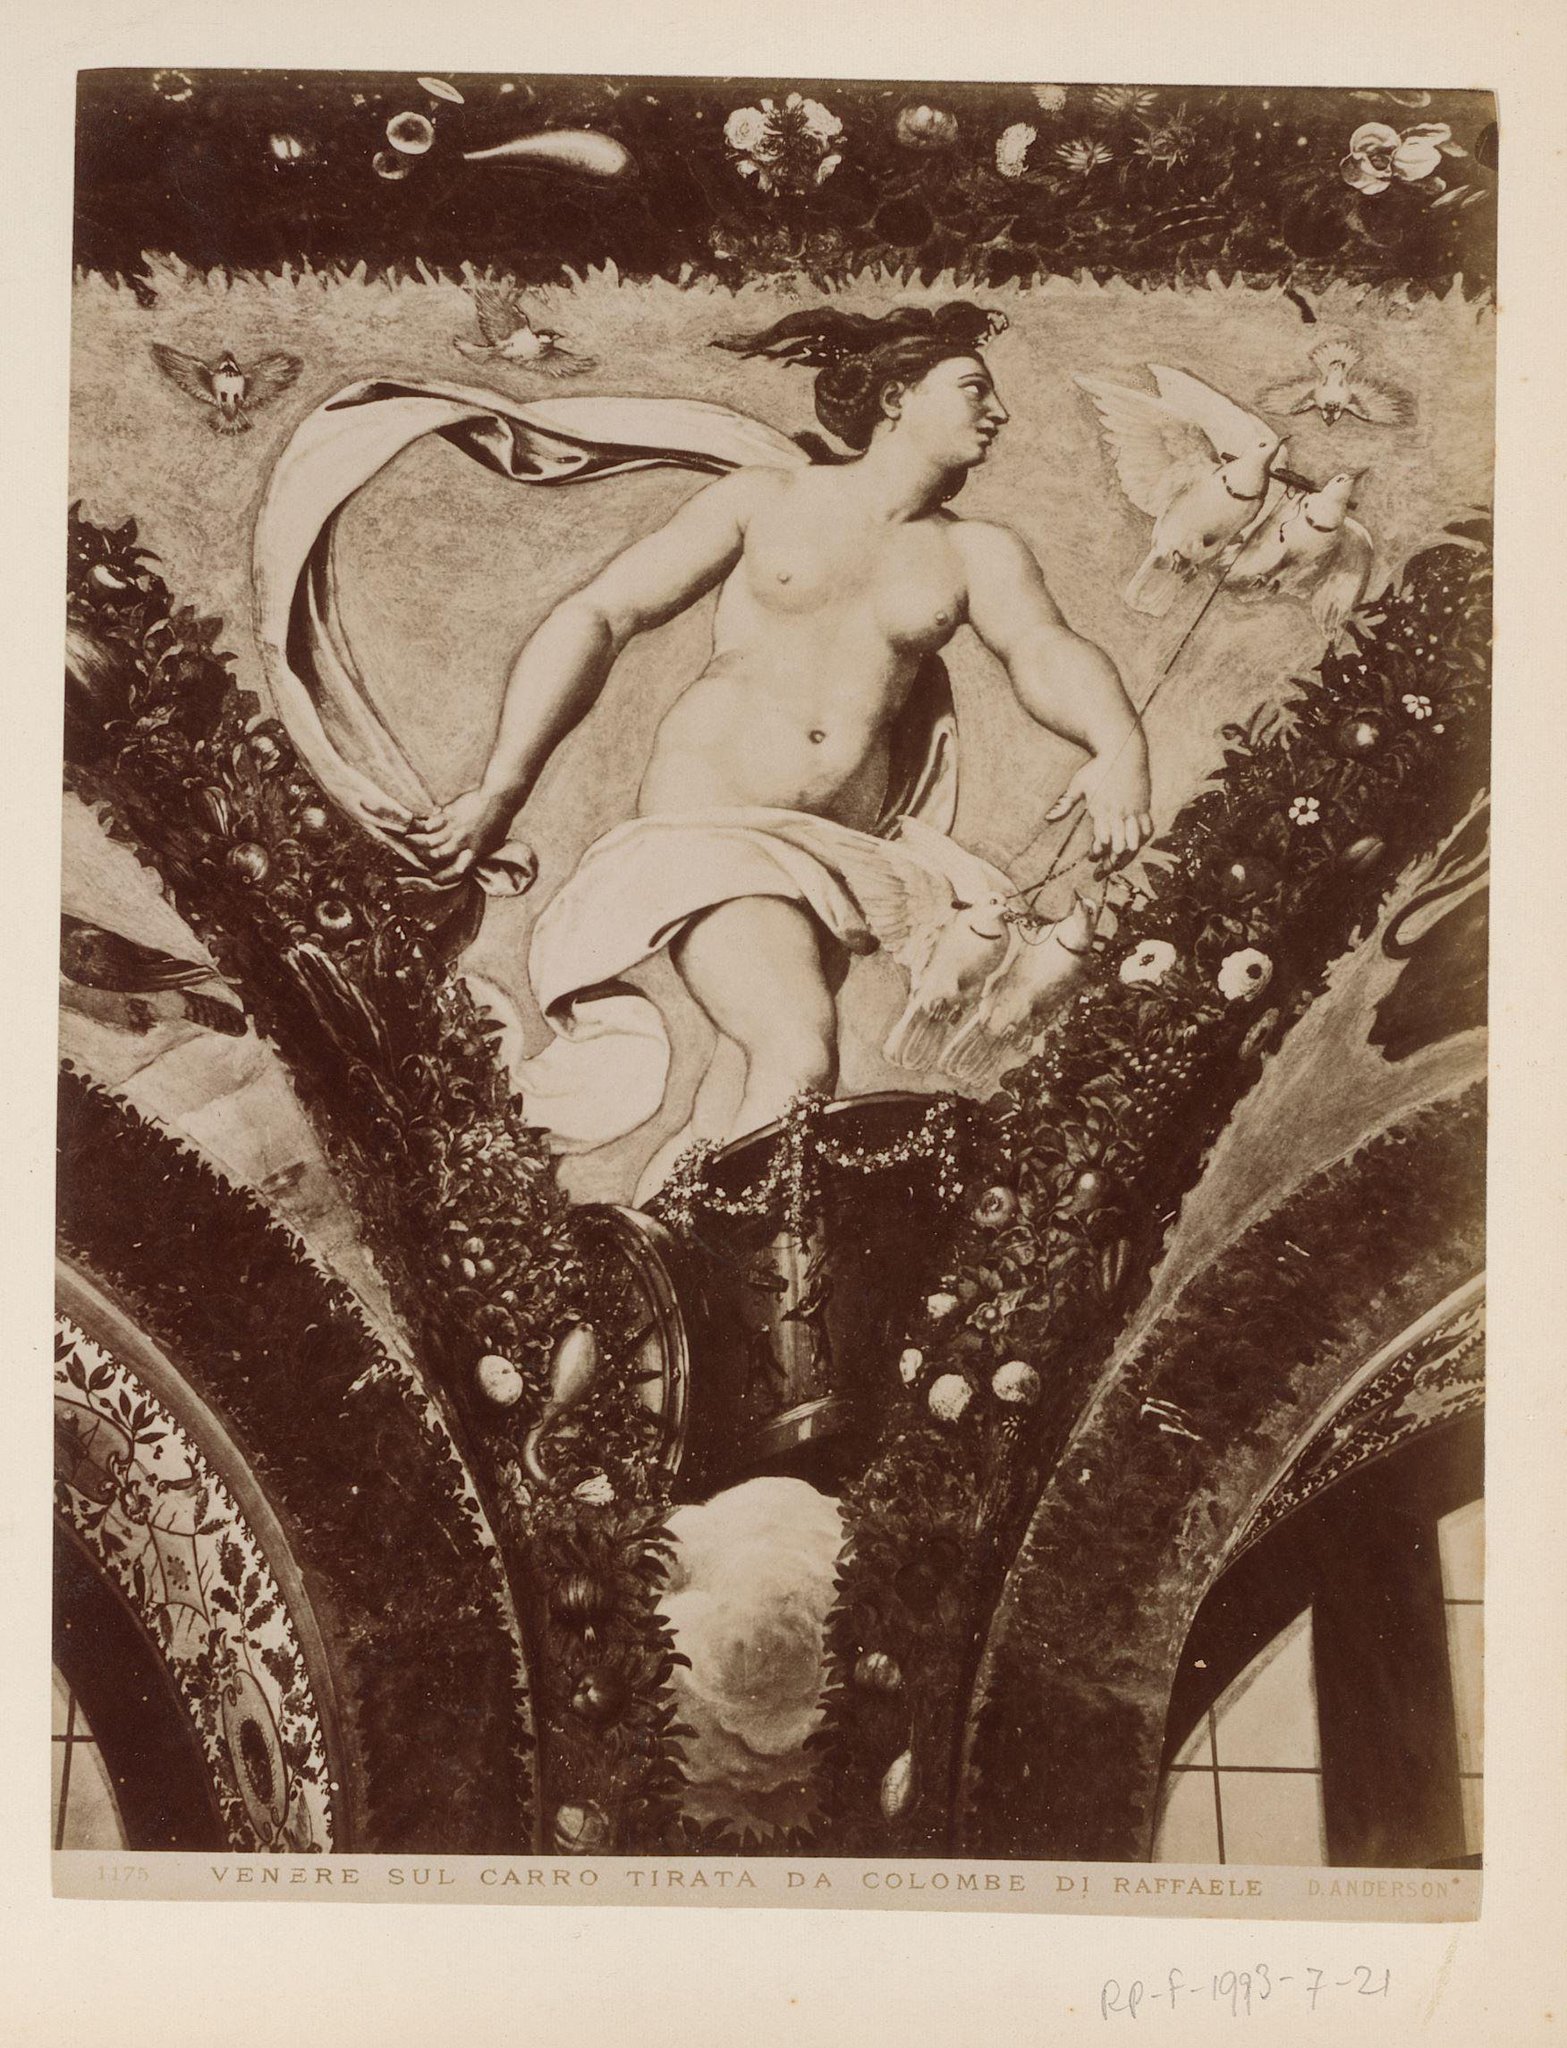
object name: photograph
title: Fotoreproductie van fresco Venus begeeft zich naar de Olympos, door Rafaël in het Farnesina te Rome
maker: domenico anderson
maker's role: fotograaf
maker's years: 1854-1939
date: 1870-1890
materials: paper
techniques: albumen print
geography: villa farnesina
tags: picture, painting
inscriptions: inscription: ‘1175 VENERE SUL CARRO TIRATA DA COLOMBE DI RAFFAELE D. Anderson’